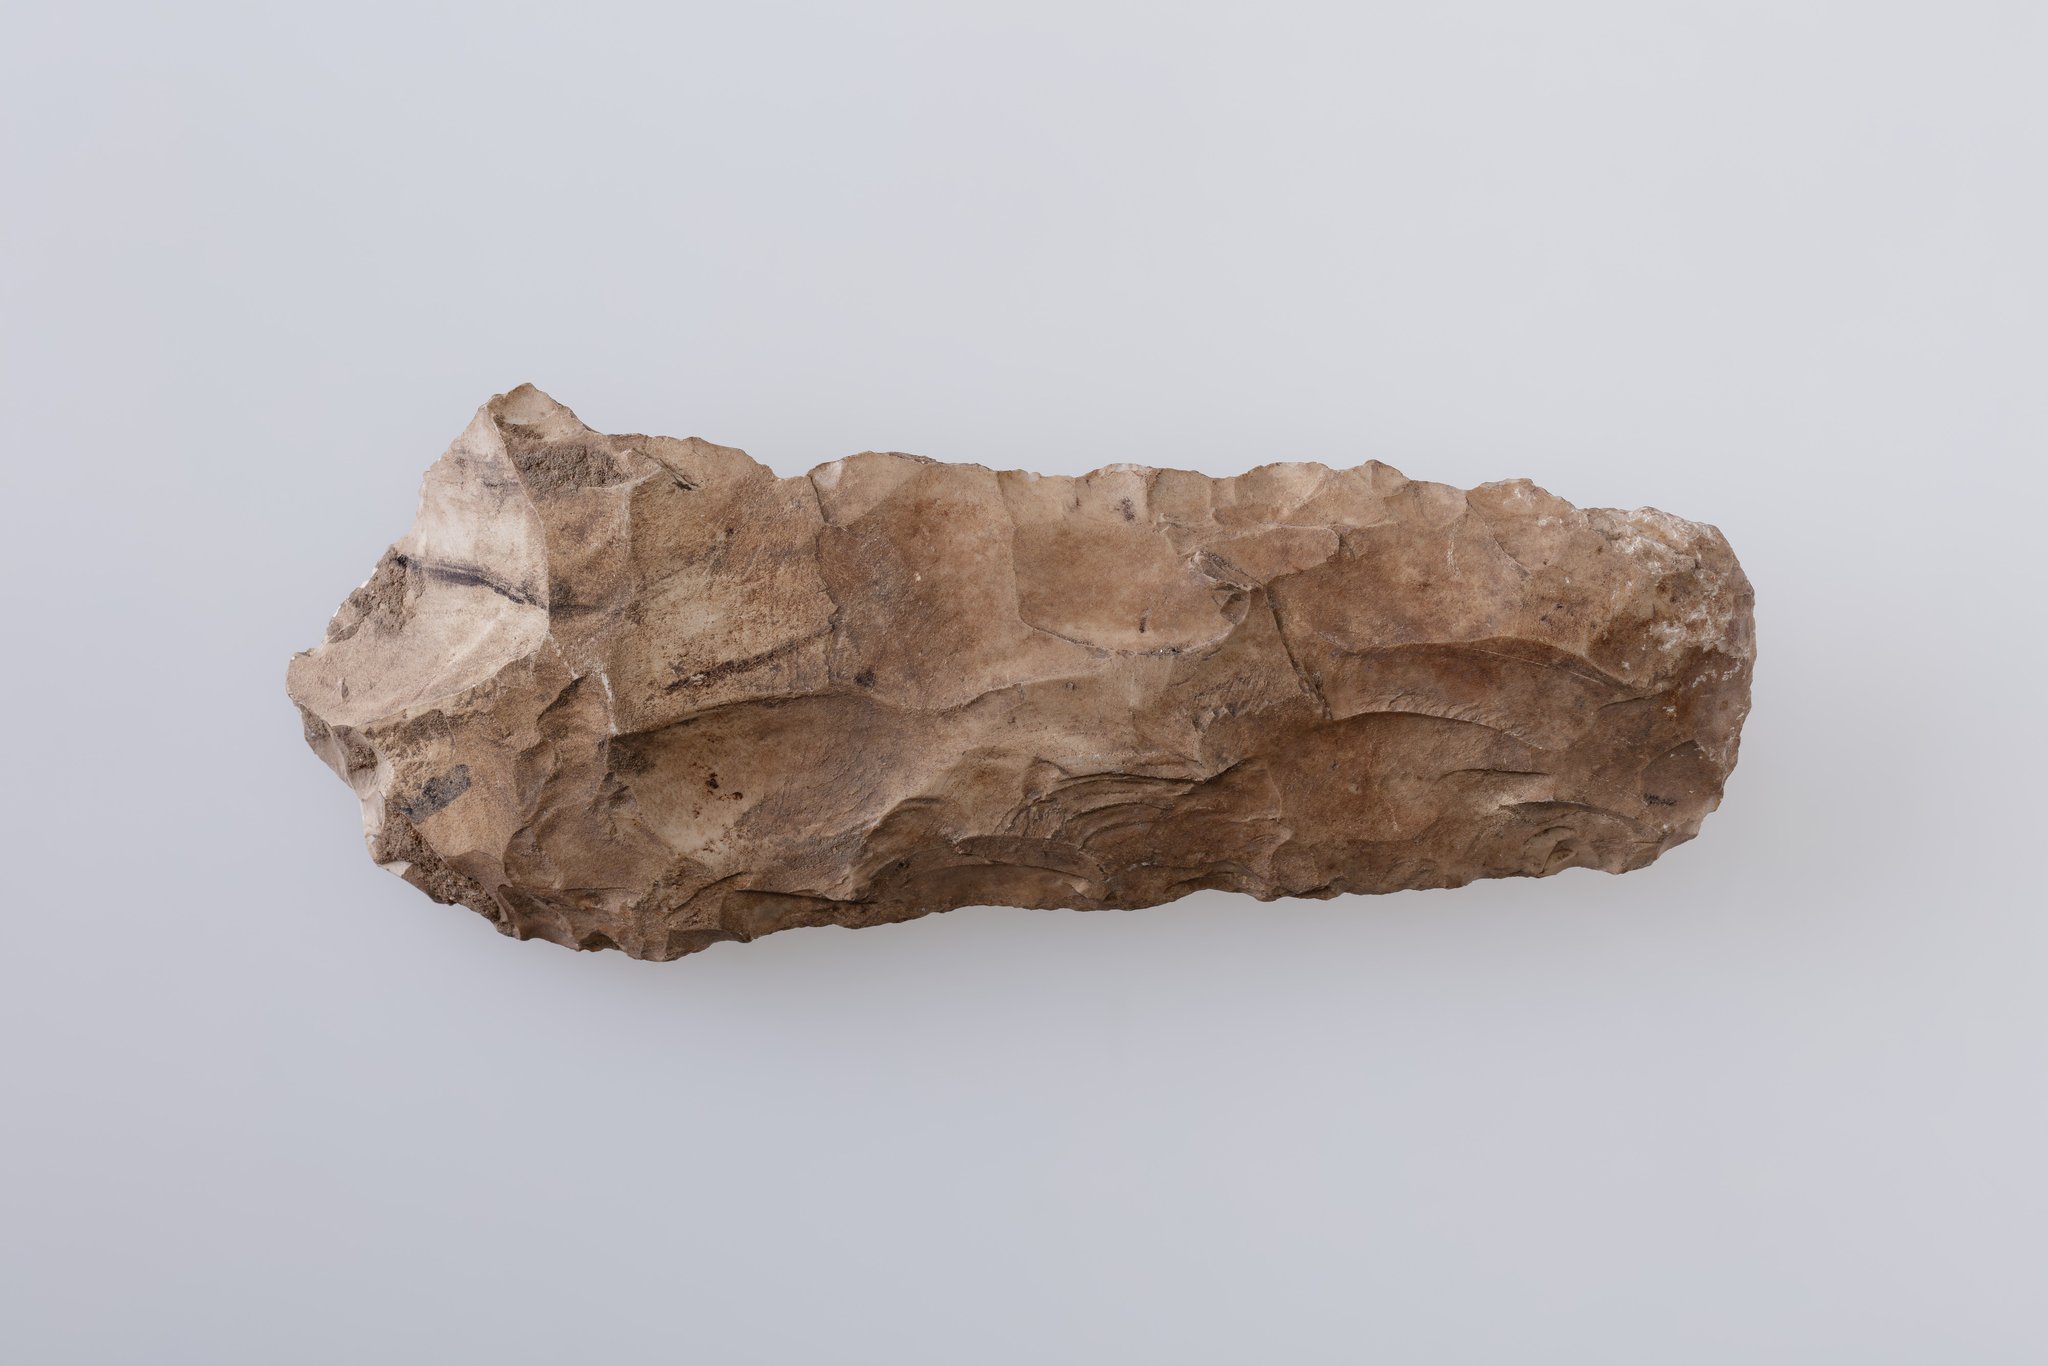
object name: tool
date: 3100-2649 BCE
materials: stone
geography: egypt